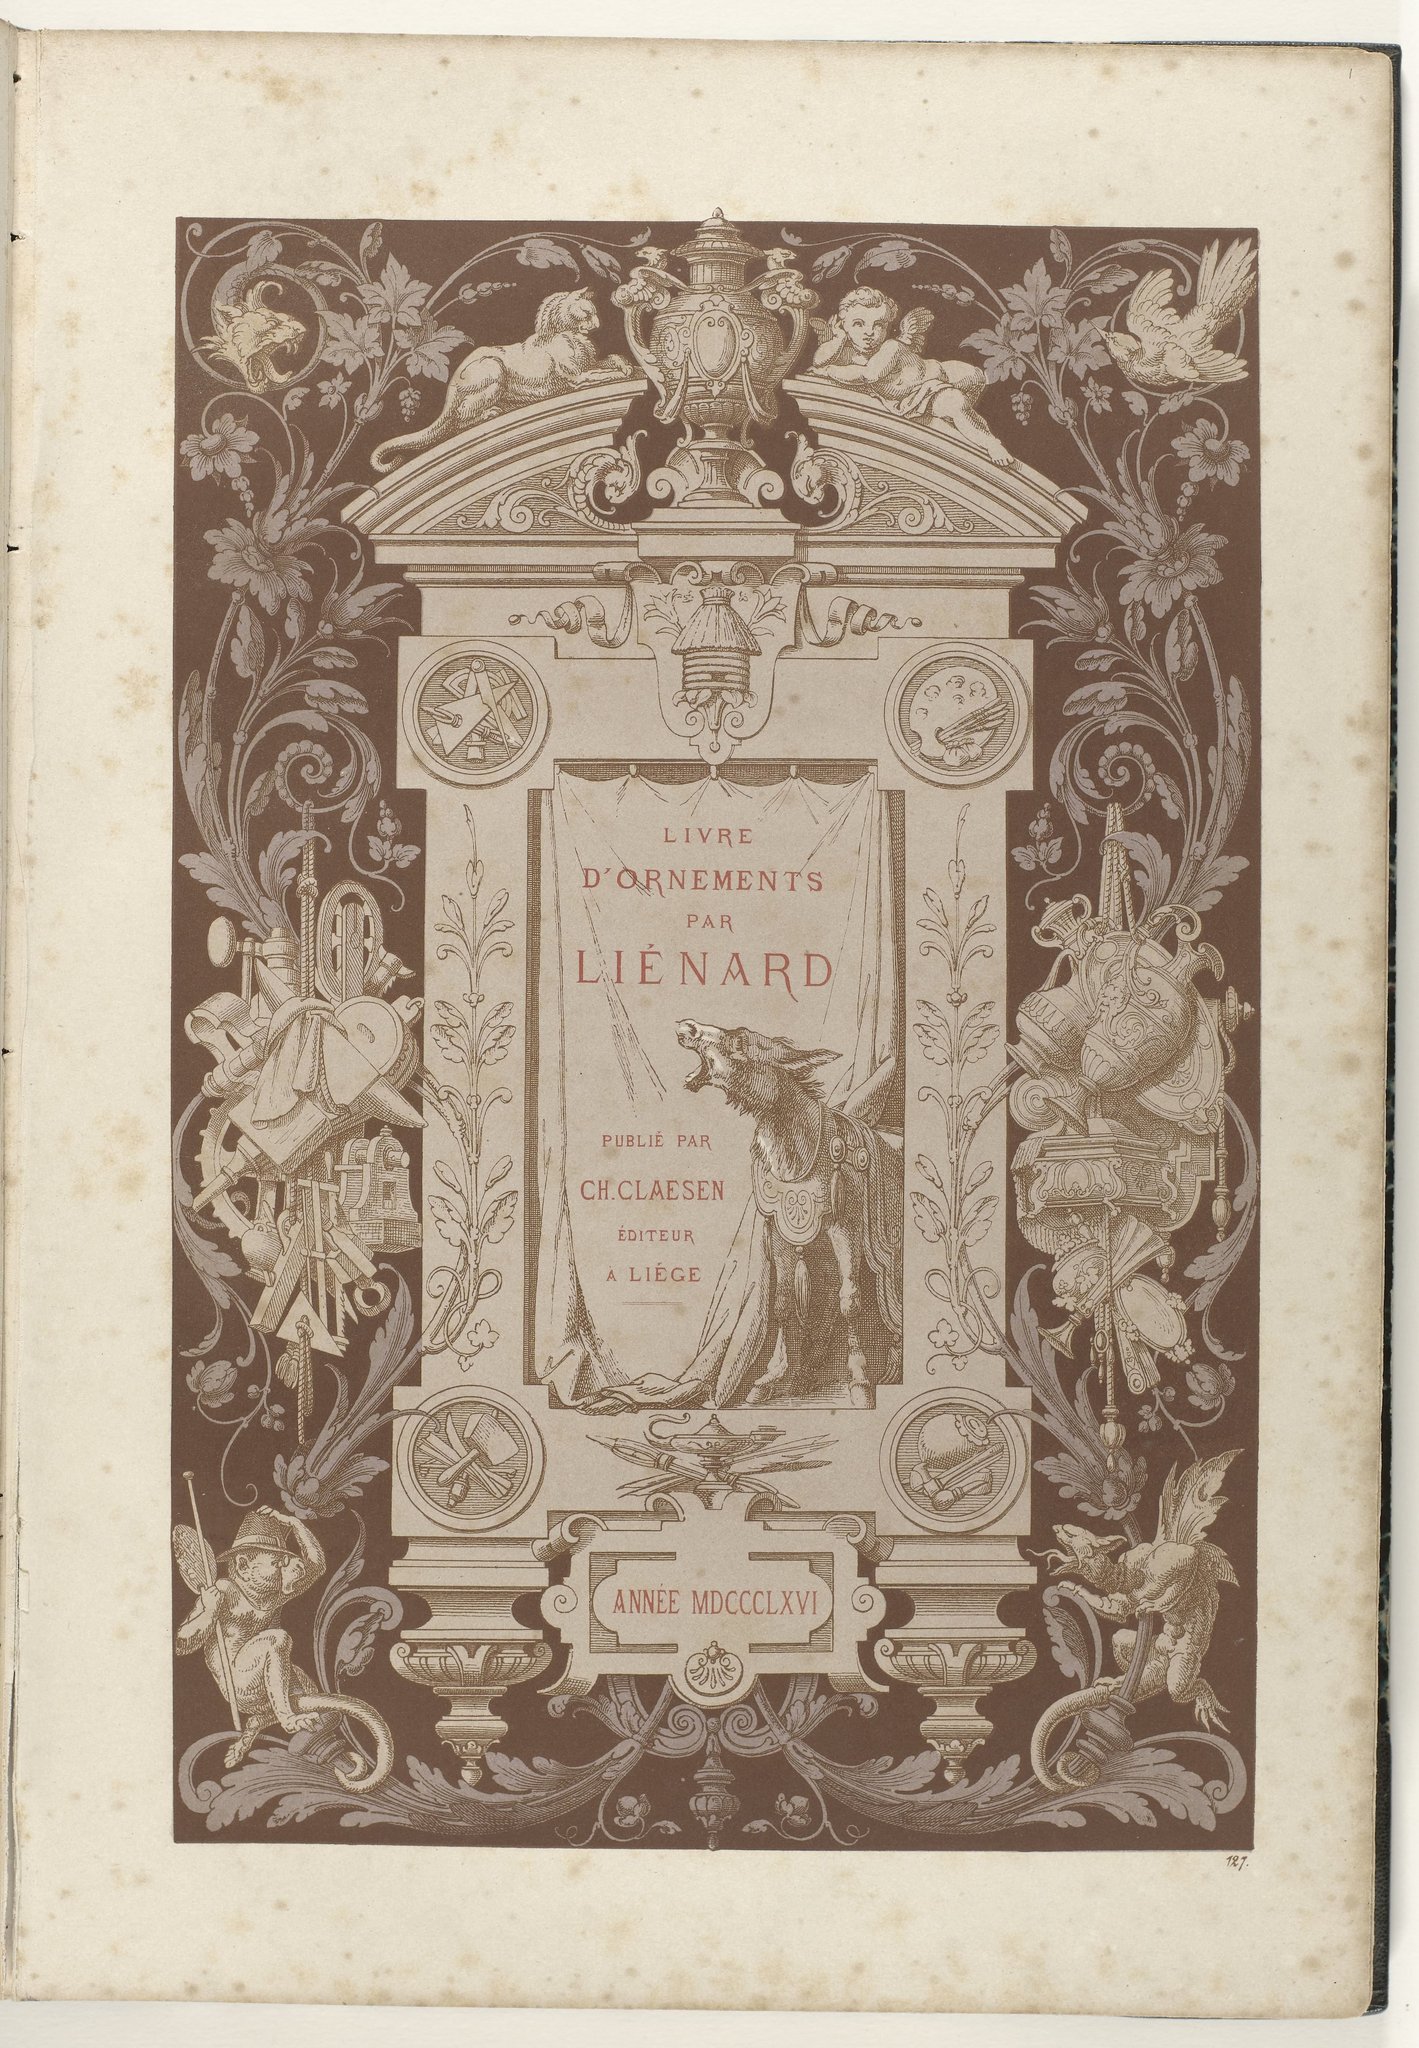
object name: print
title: Rechthoekige cartouche tussen trofeeën, dieren en bladranken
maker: michel liénard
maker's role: print maker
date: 1866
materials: paper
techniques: tone lithography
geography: liège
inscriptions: date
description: De titel staat afgebeeld op een doek waar een balkende ezel onder vandaan komt. Het blad is rechtsonder genummerd: 127.